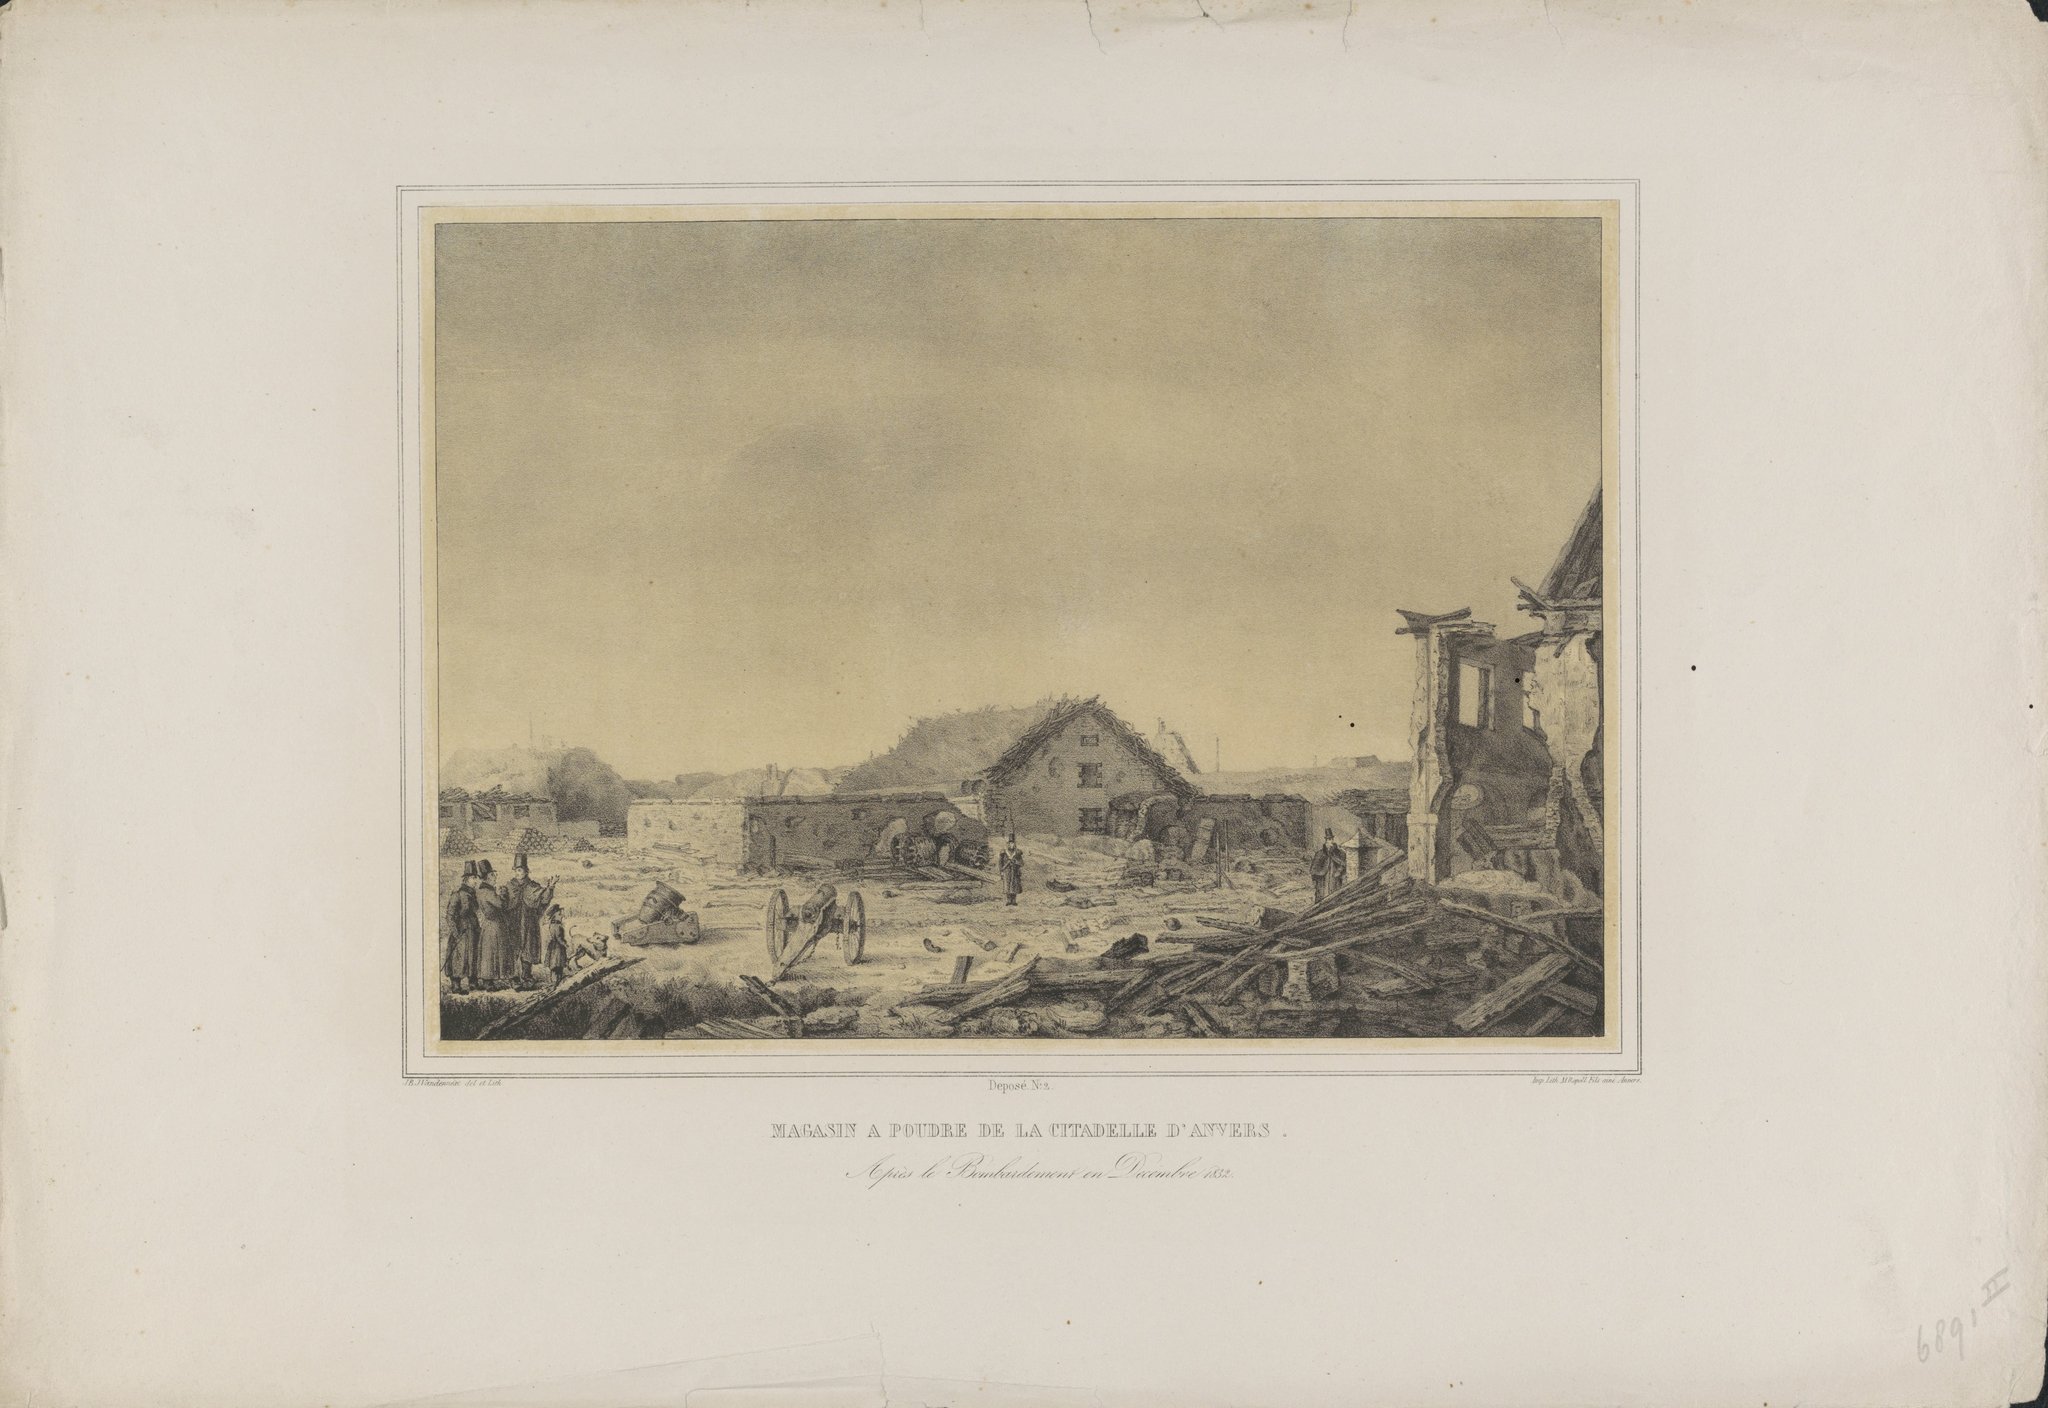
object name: print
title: Album de sept vues des Ruines de l'intérieur de la Citadelle d'Anvers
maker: joseph van den nest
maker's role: print maker, publisher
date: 1832-1833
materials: paper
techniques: tone lithography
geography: antwerp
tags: permanent fortifications, devastated, ruined place or city (~ warfare)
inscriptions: collector's mark: Lugt 2228, : ‘Deposé’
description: Interieur van de citadel met de ruïnes van de kruitmagazijn. Onderdeel van een serie met een titelprent en zeven platen van de ruïnes in het interieur van de Citadel van Antwerpen, na de overgave in december 1832.